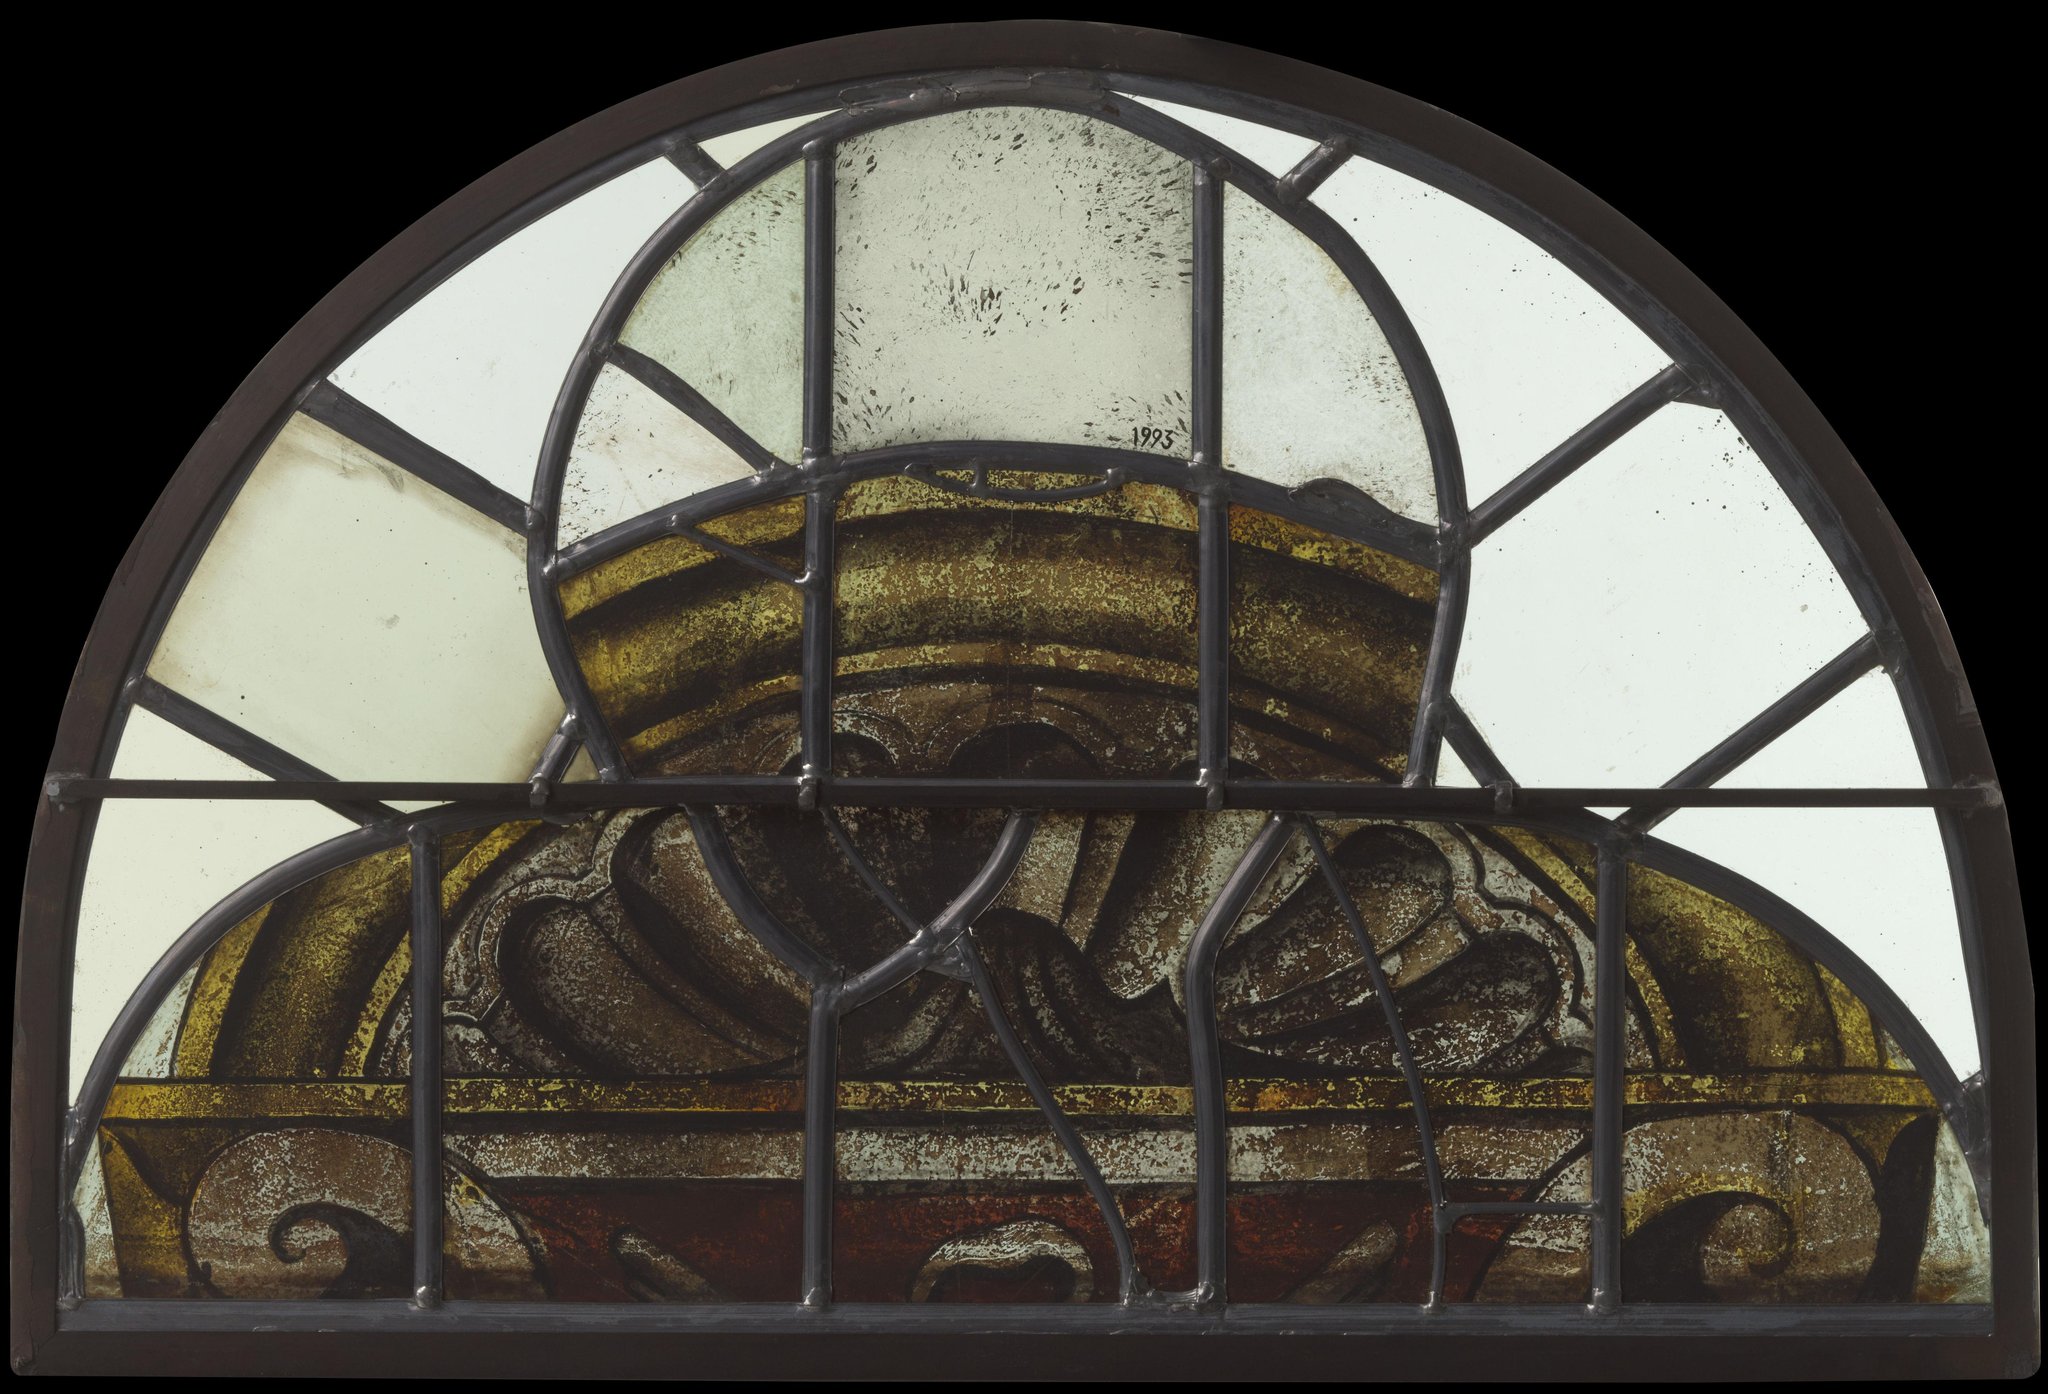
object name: light window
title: Zeventiende paneel van ruit met Prins Maurits in biddende houding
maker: Anonymous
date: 1618-1620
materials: glass, lead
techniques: leading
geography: netherlands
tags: maurice (prince of orange)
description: Groot raam afkomstig uit het klooster van St Agatha bij Cuyk. Prins Maurits in verguld harnas, met hermelijnen mantel en geplooide kraag, blootshoofds, in biddende houding, geknield op een bidstoel voor een lessenaar waarop een boek. De lessenaar staat op een tafel met een donkerblauw kleed met gouden franje gedekt. Helm en handschoenen liggen op de grond voor de tafel. De prins bevindt zich in een koepel door vier vrijstaande Korintische zuilen gedragen; boven zijn hoofd een baldakijn waaruit een lauwerkrans afhangt. De koepel wordt bekroond door het wapen van Maurits en het devies van de Orde van de Kousenband: 'Honi soit qui mal y pense' (Schande over hem die er kwaad van denkt). Wapen door twee lopende jongelingen gesteund. Het wapen leunt tegen het bovenstuk van de koepel. Onder dit tafereel bevinden zich brokstukken architectuur die onoordeelkundig zijn aangebracht. Rechts ligt een jonge vrouw geknield met opgeheven handen. Zij draagt een geel zijden mantel met hermelijn omzoomd. Het gezicht is in olieverf bijgemaakt in 1891.